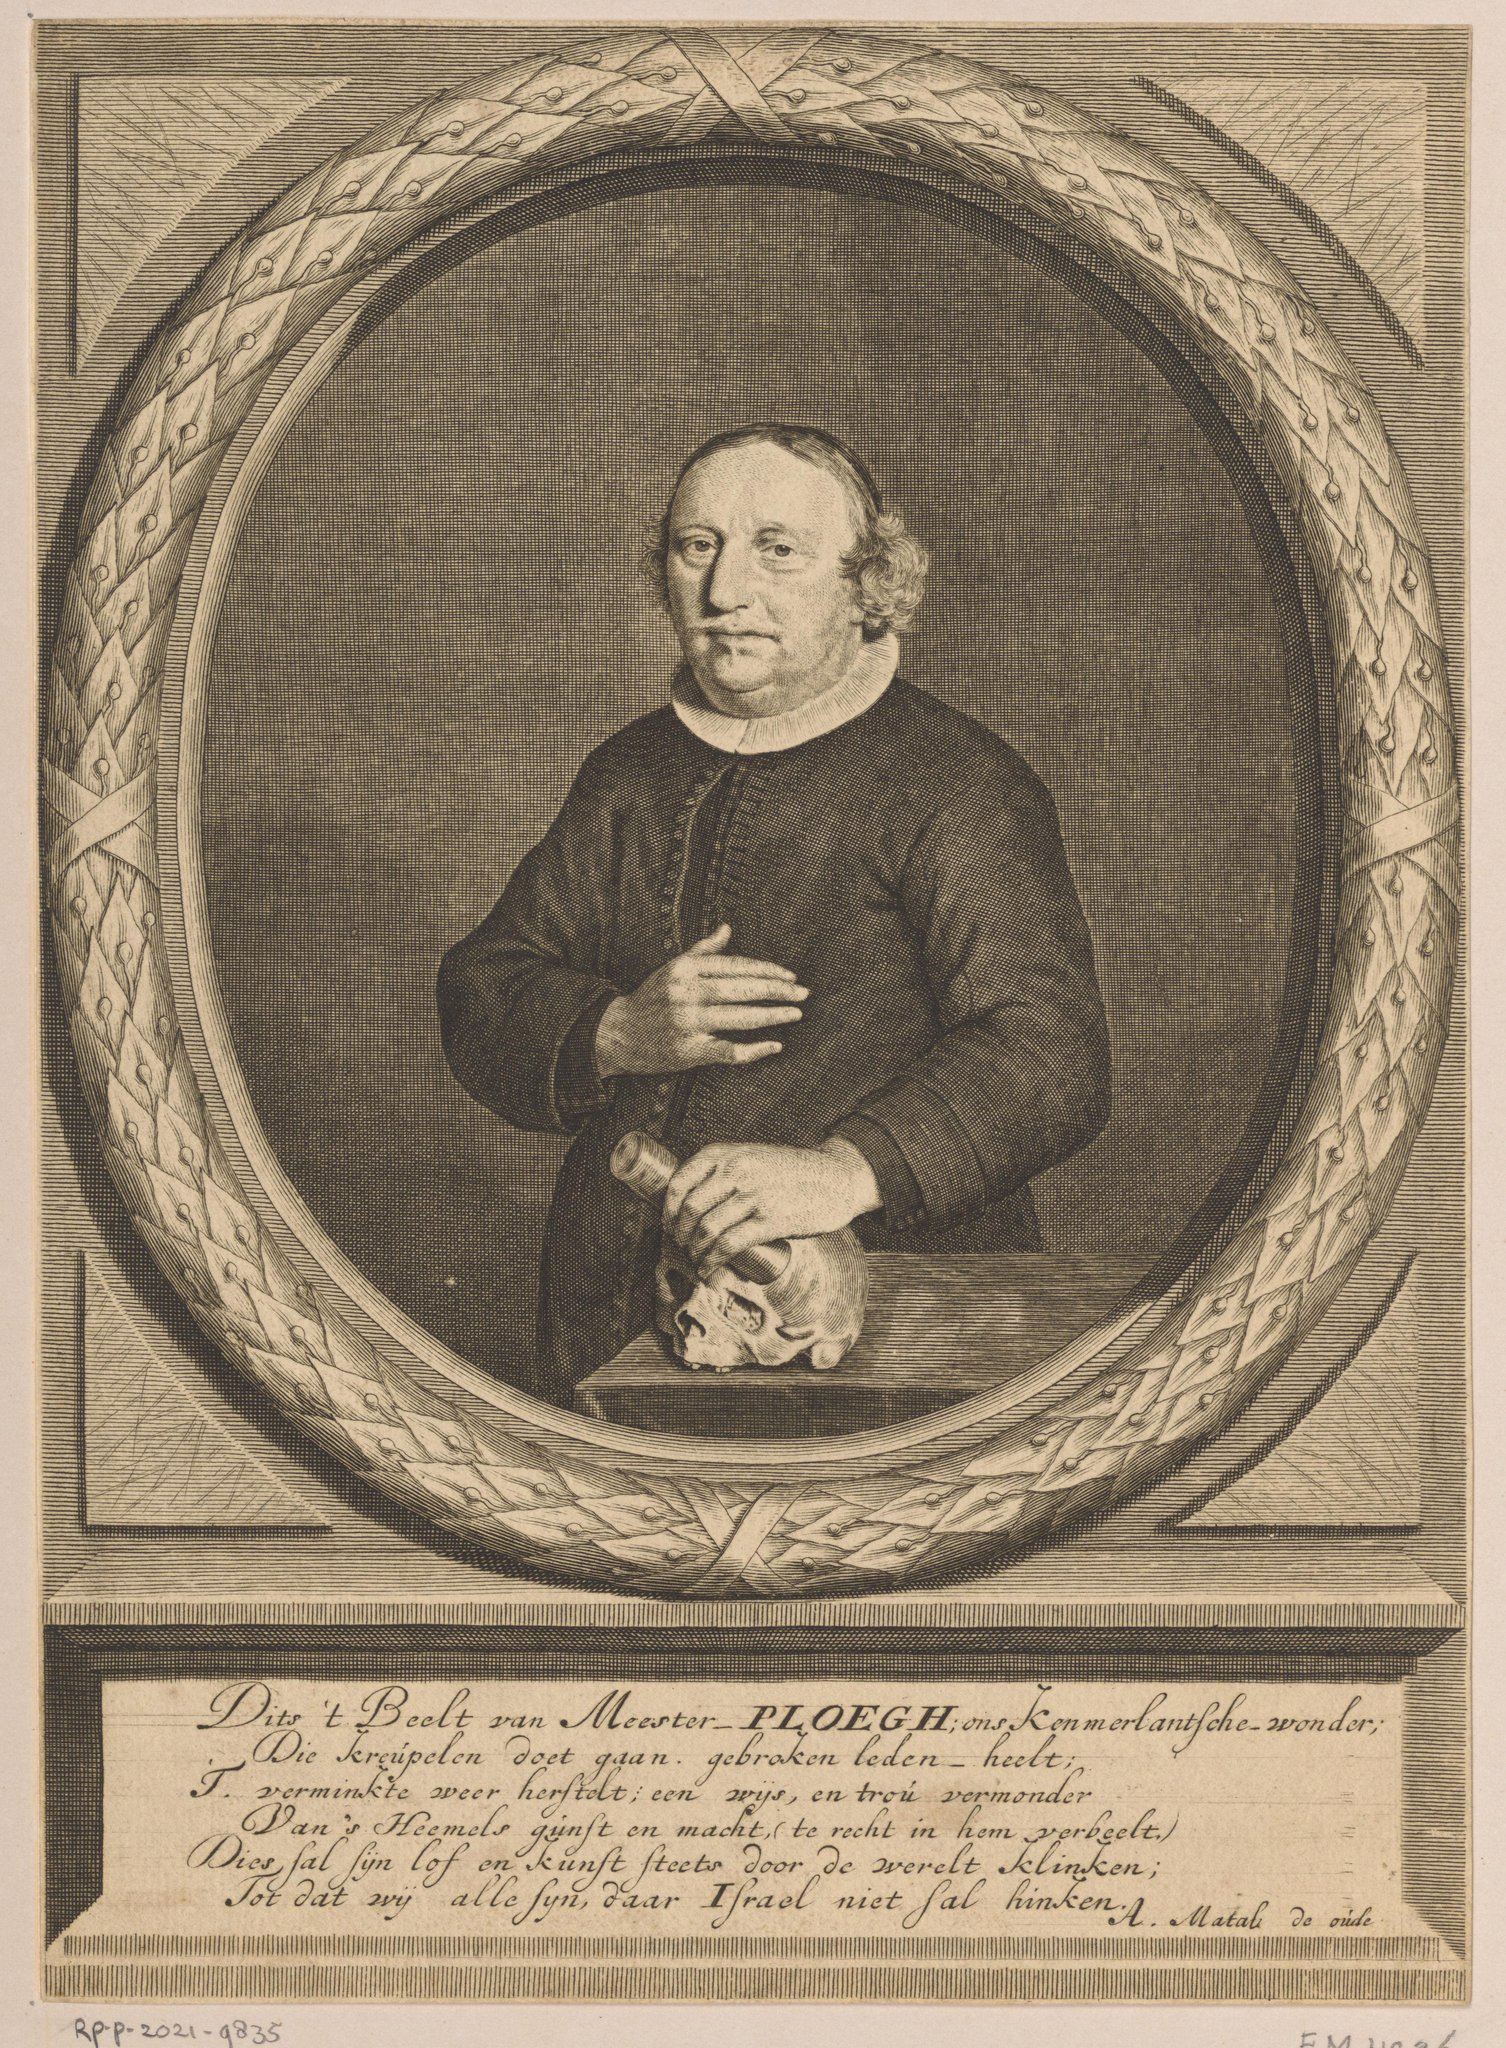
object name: print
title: Portret van Cornelis van den Ploegh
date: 1682-1749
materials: paper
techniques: engraving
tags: adult man, historical persons, physician, doctor, death's head, skull (symbol of death)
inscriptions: initials: ‘A. Matali de oude’